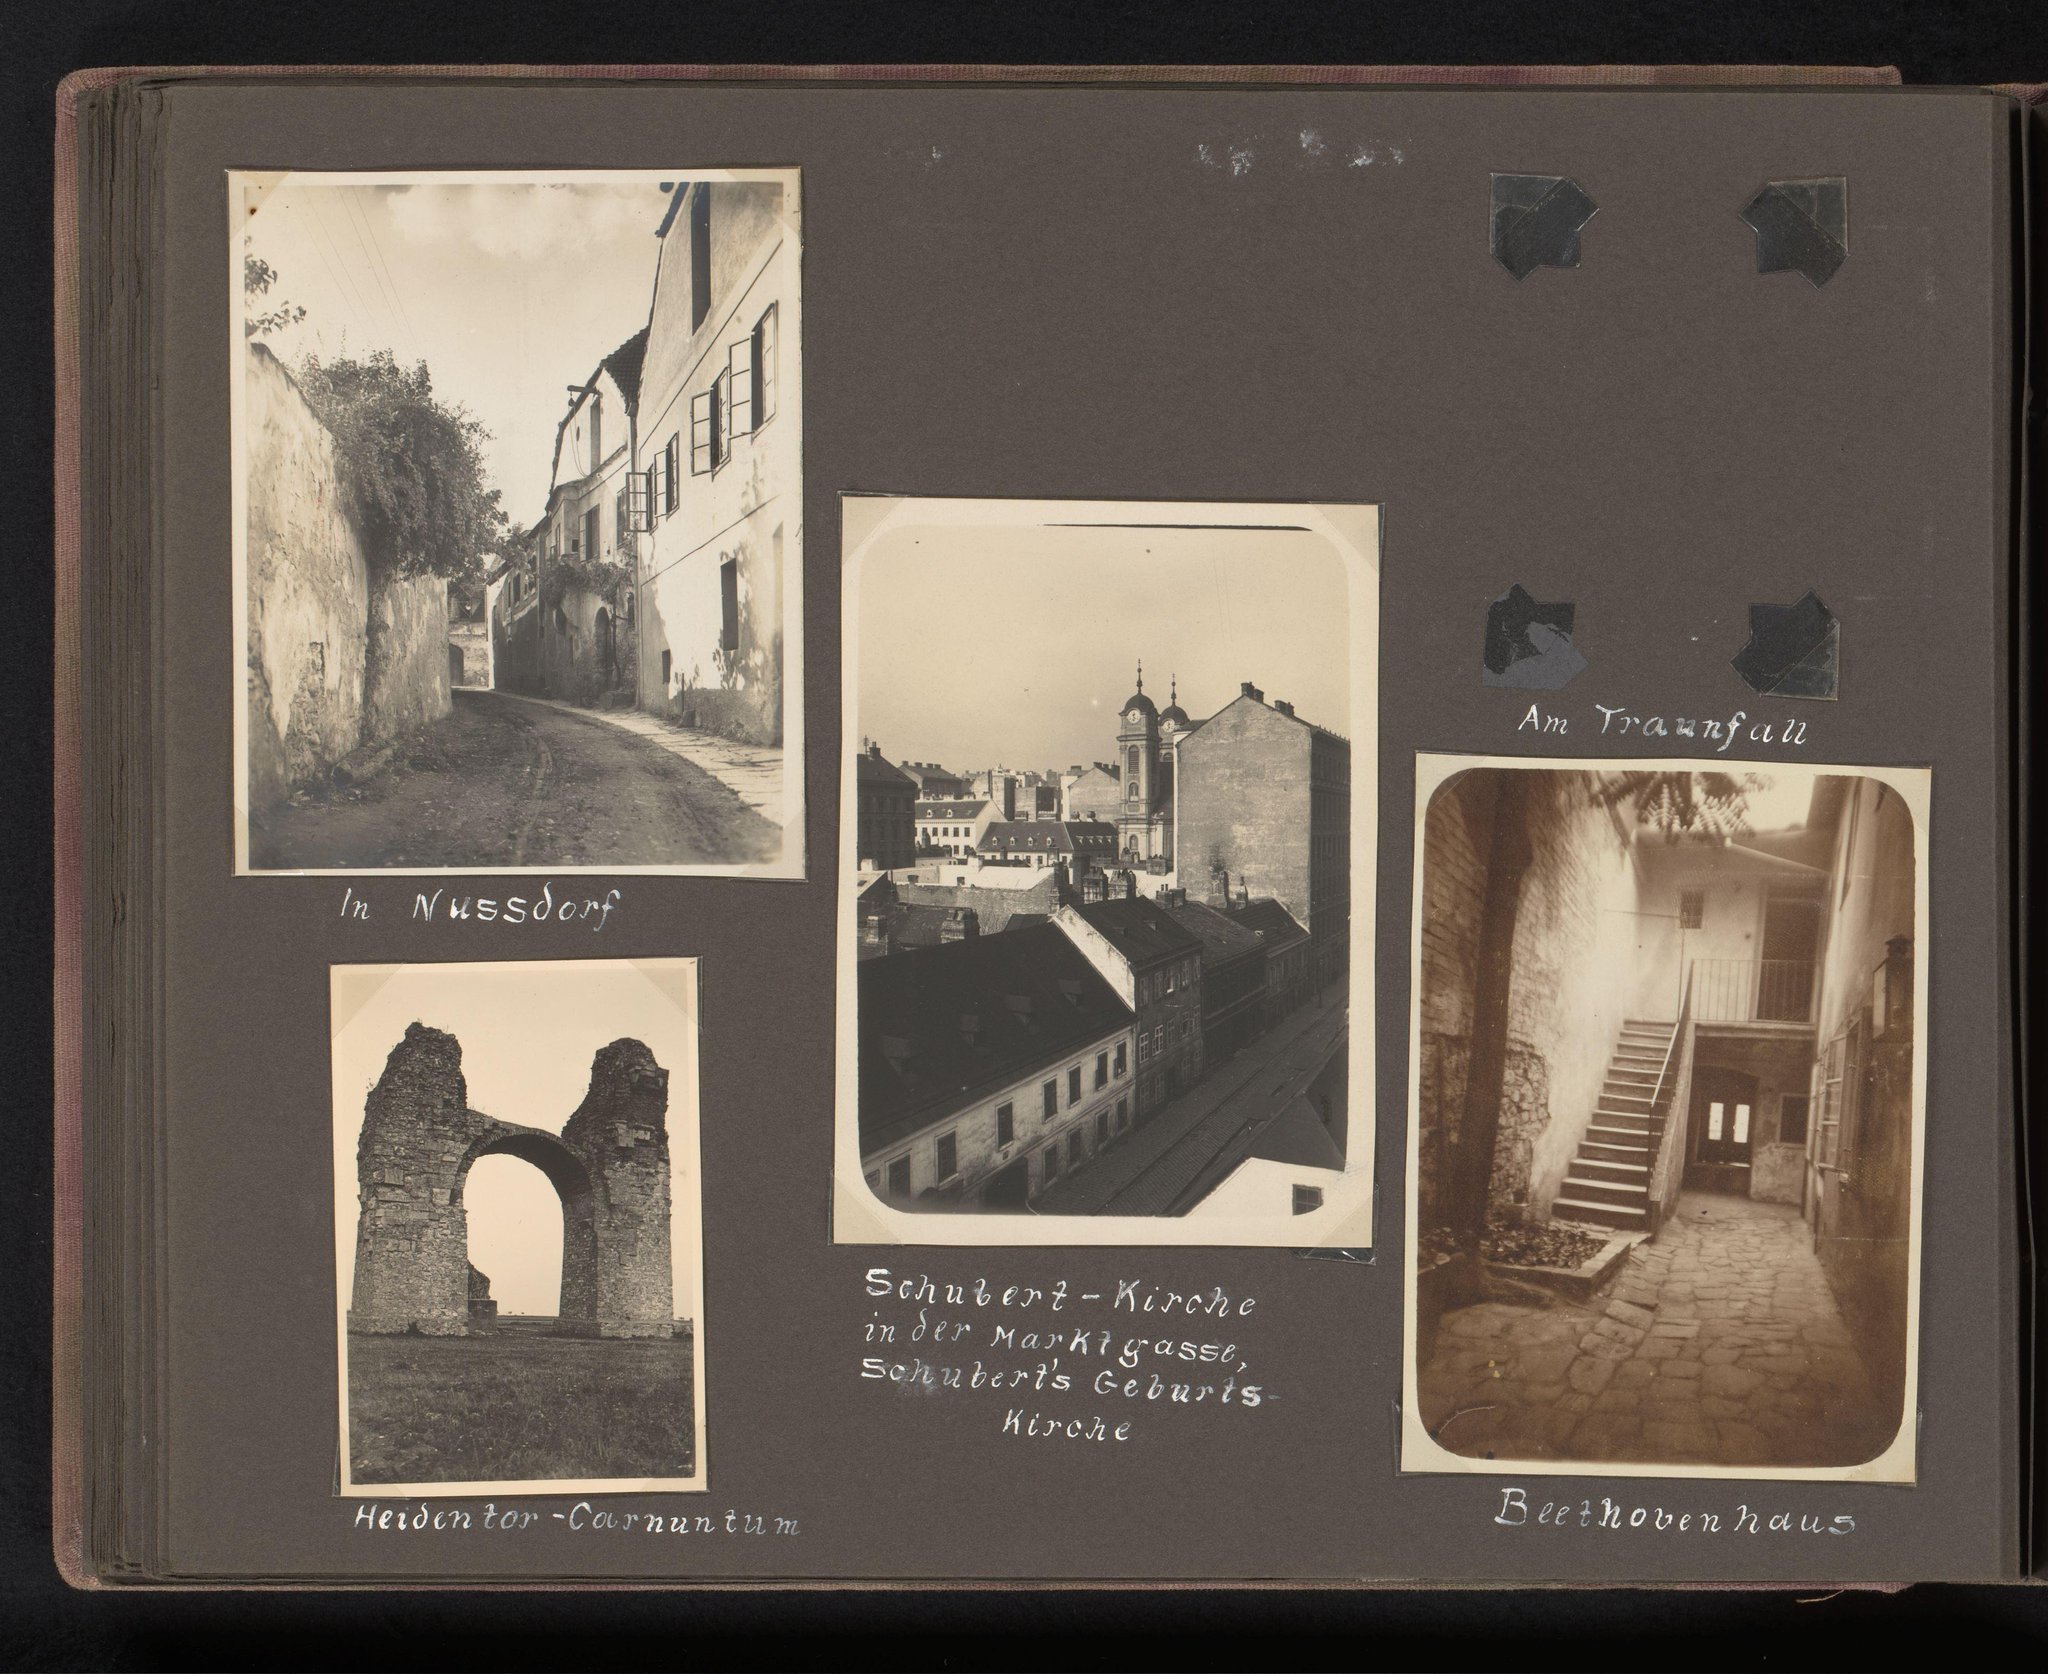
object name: photograph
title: Bezienswaardigheden in Wenen en omstreken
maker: berti hoppe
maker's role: fotograaf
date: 1930-1931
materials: cardboard, photographic support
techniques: gelatin silver print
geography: vienna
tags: church (exterior), permanent exhibition, museum, street, city-gate, vienna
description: Vier foto's van bezienswaardigheden in Wenen. In de onderschriften is vermeld dat het gaat om: Nussdorf, de Heidentor in Petronell-Carnuntum, de Schubertkirche en het Beethovenhaus. Er ontbreekt één foto op het albumblad. Deze foto's maken deel uit van een album.